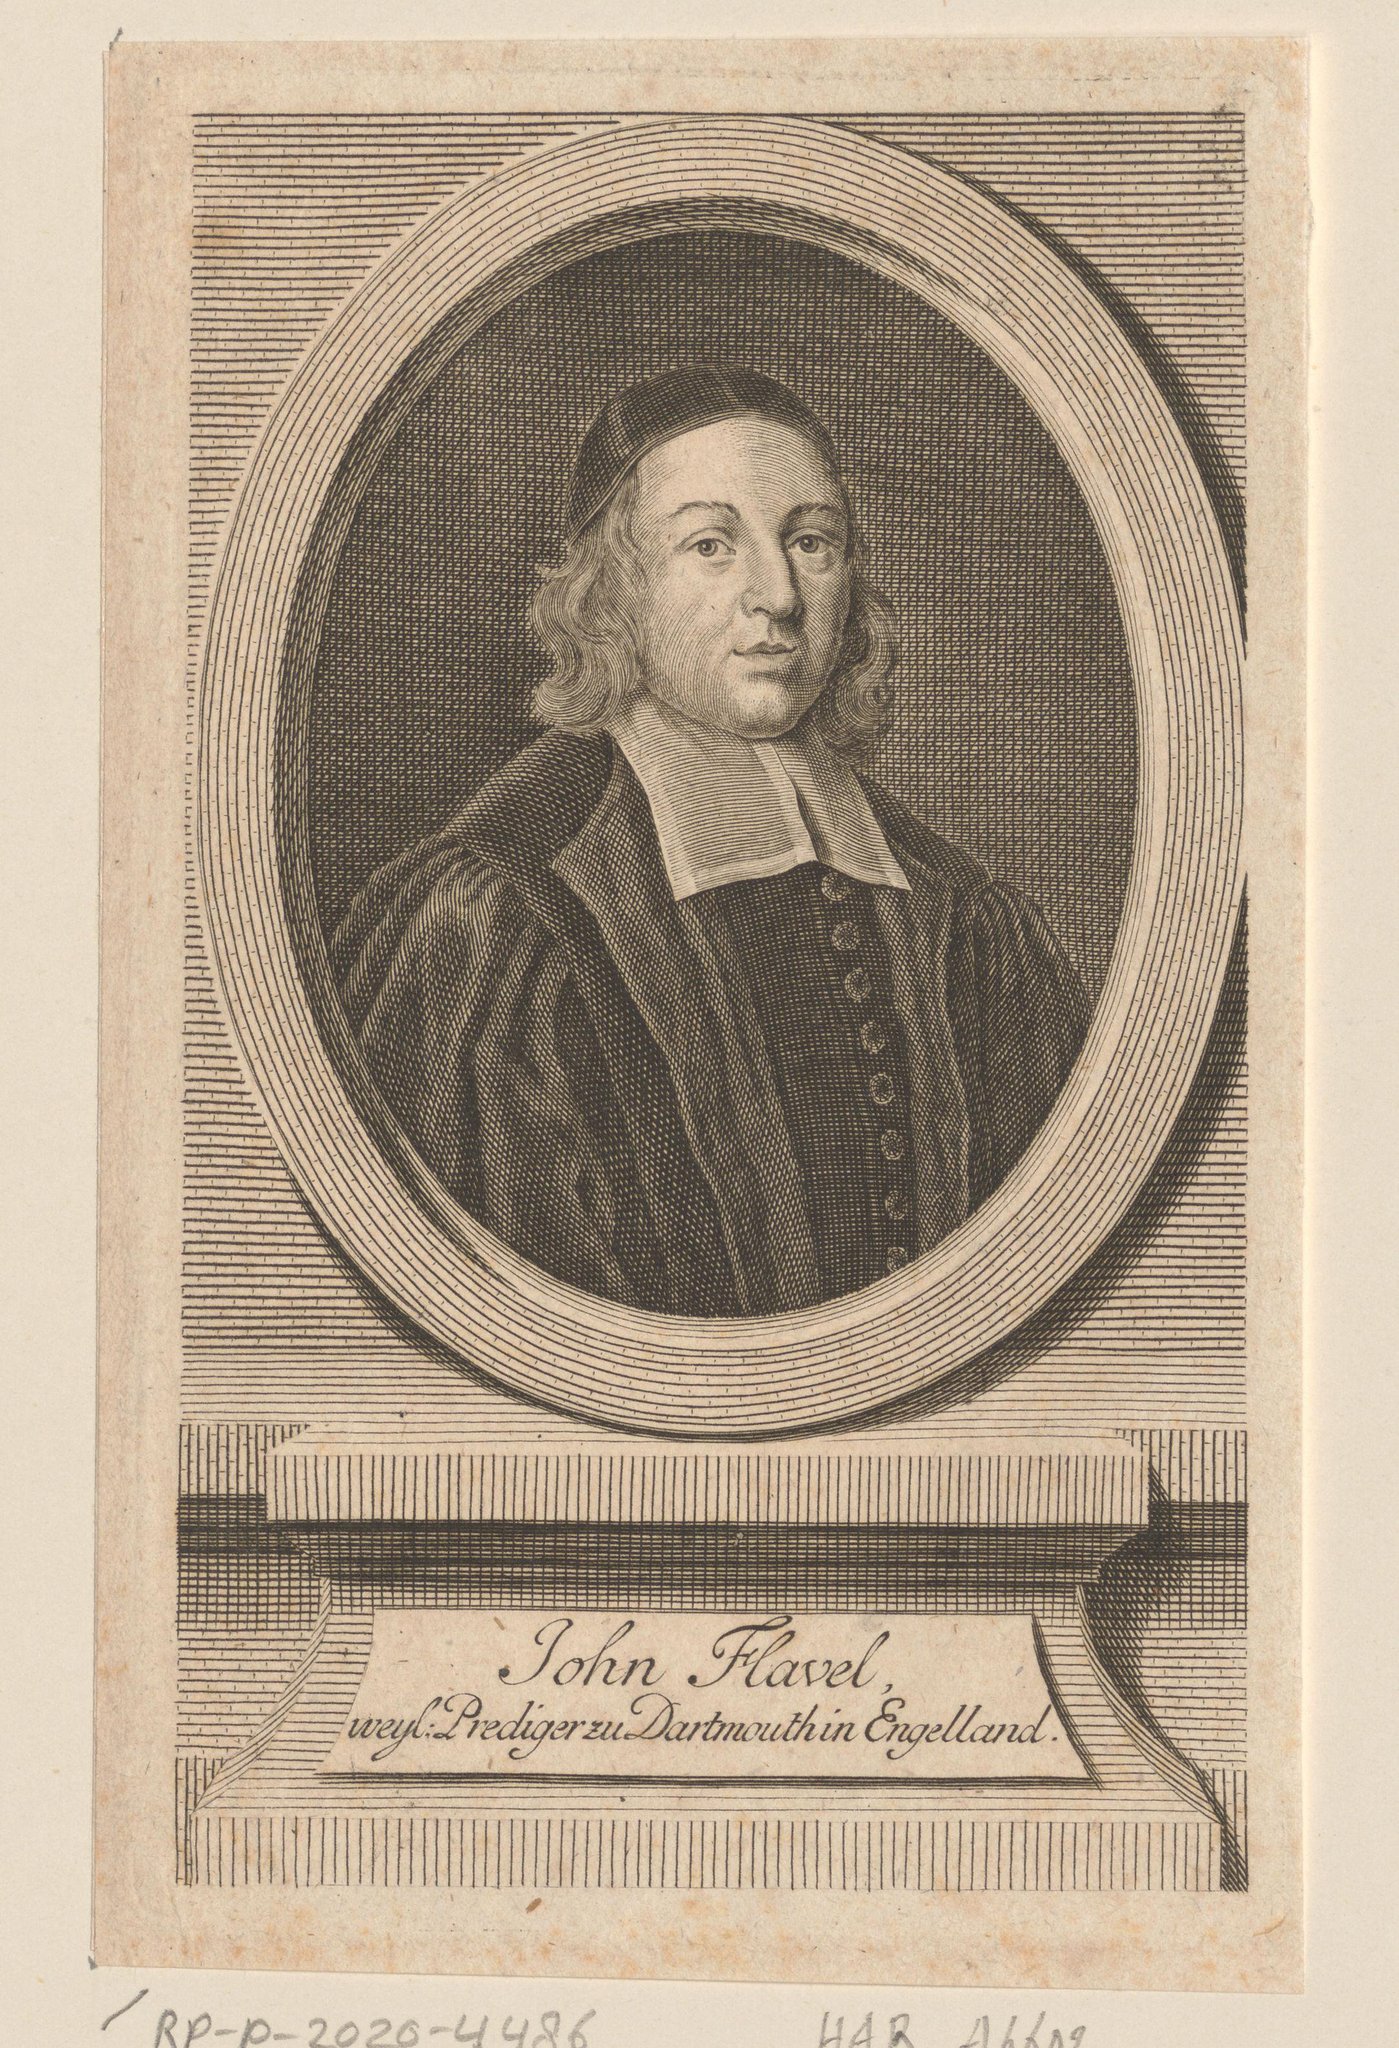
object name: print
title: Portret van John Flavel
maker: johann martin bernigeroth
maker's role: print maker, publisher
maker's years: 1713-1767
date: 1680-1750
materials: paper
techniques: engraving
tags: historical persons, portrait of a writer